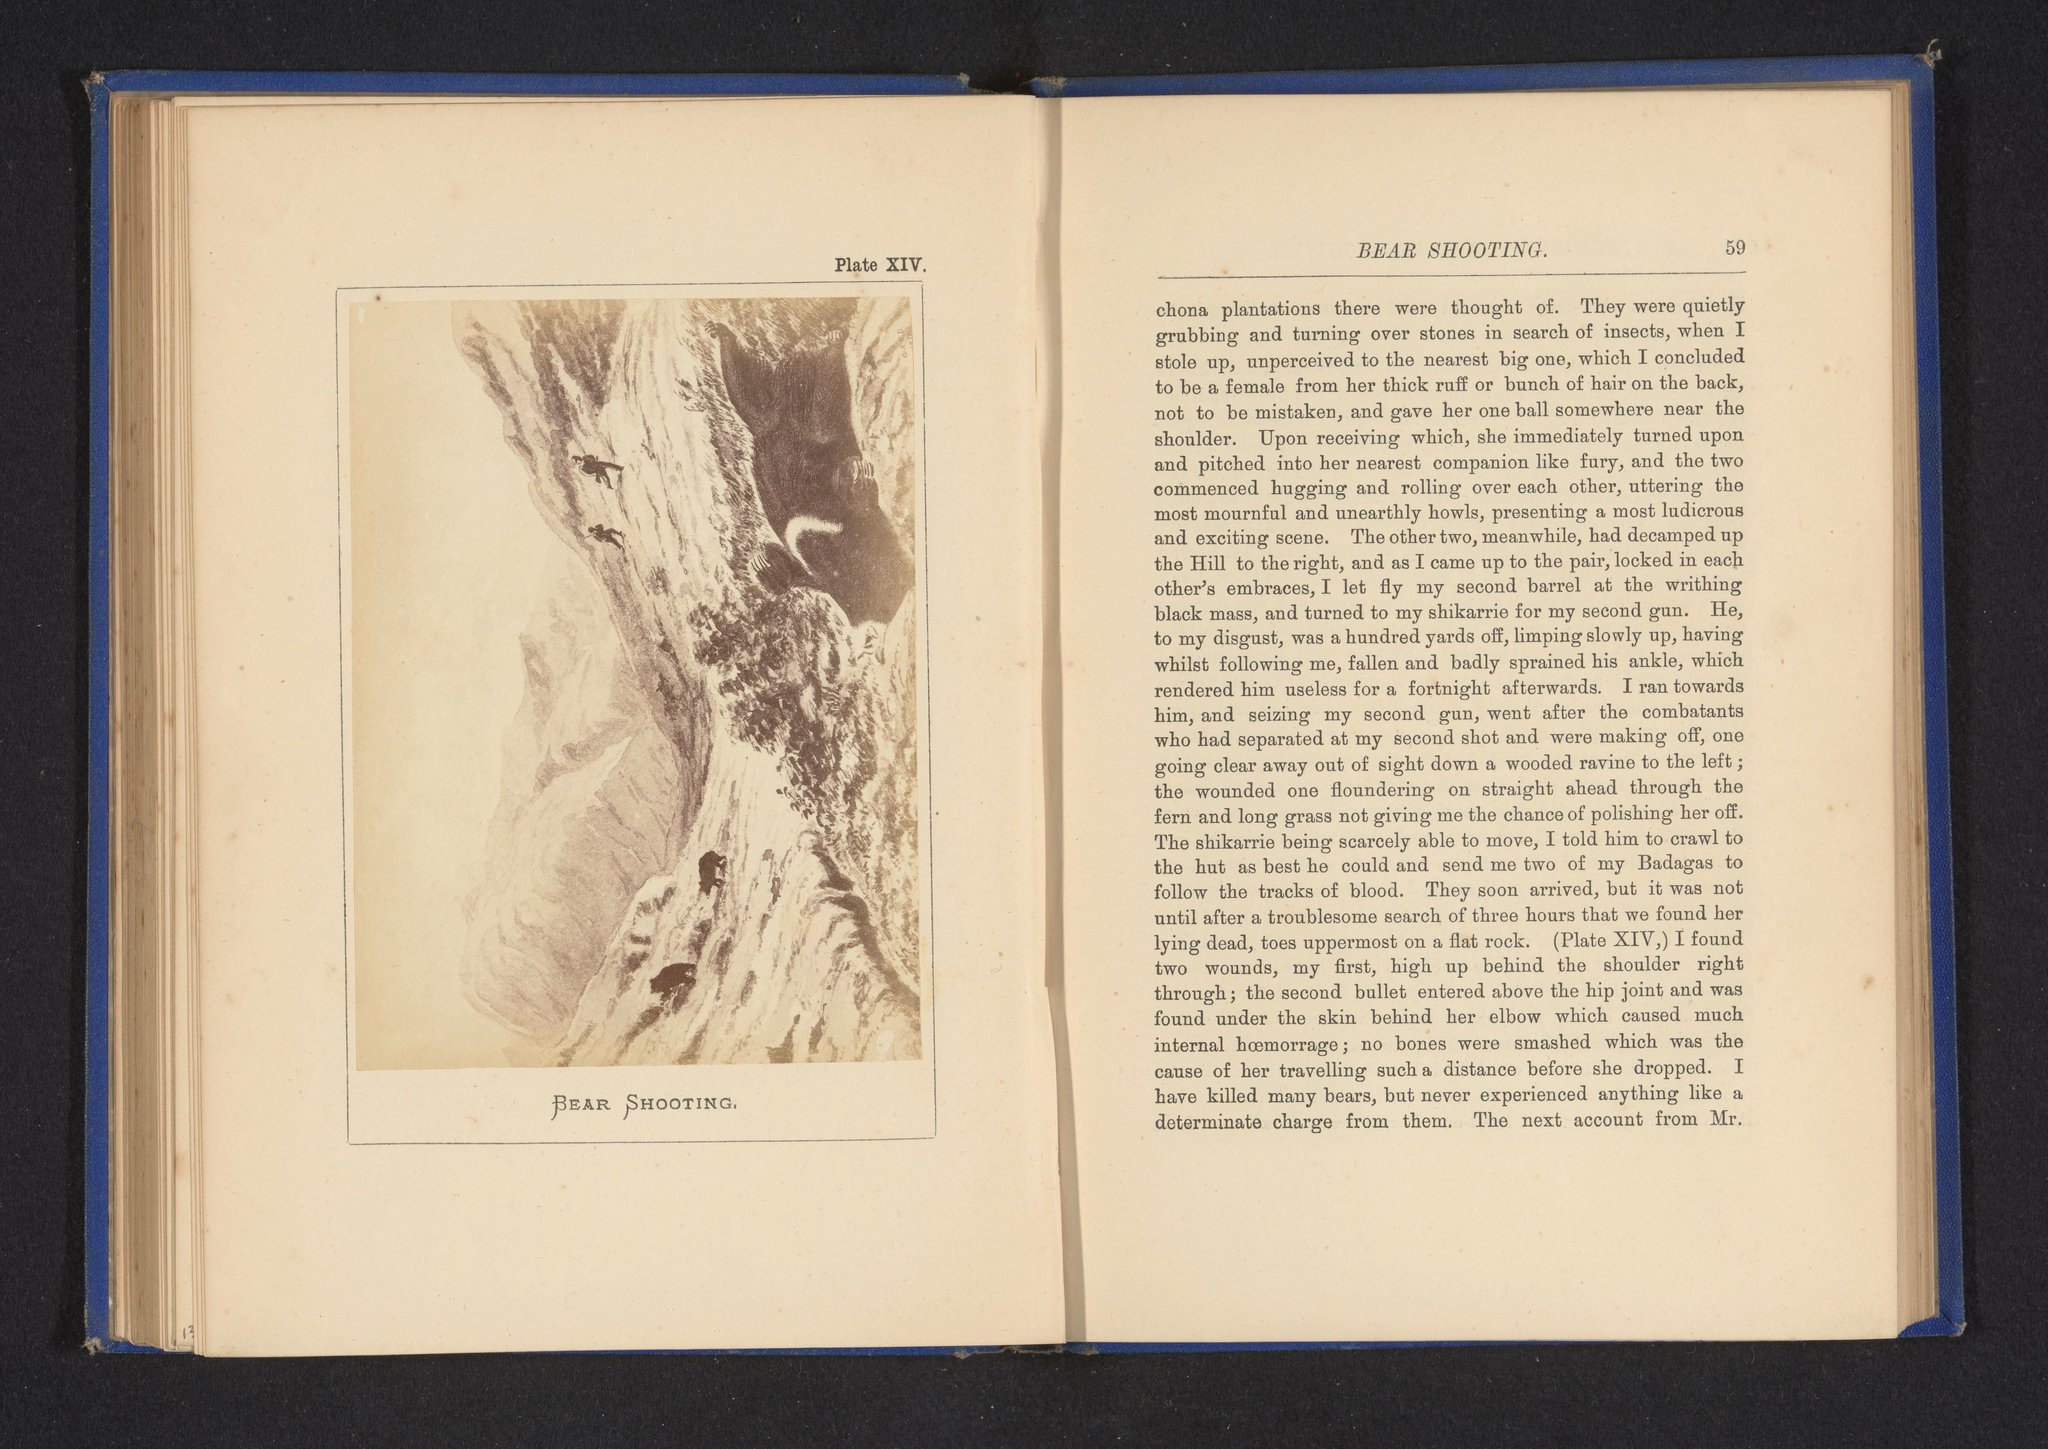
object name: photograph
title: Bear shooting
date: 1870-1880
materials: photographic support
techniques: albumen print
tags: drawing, sketch, beasts of prey, predatory animals: bear, hunt ~ mammals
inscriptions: number: ‘Plate XIV.’